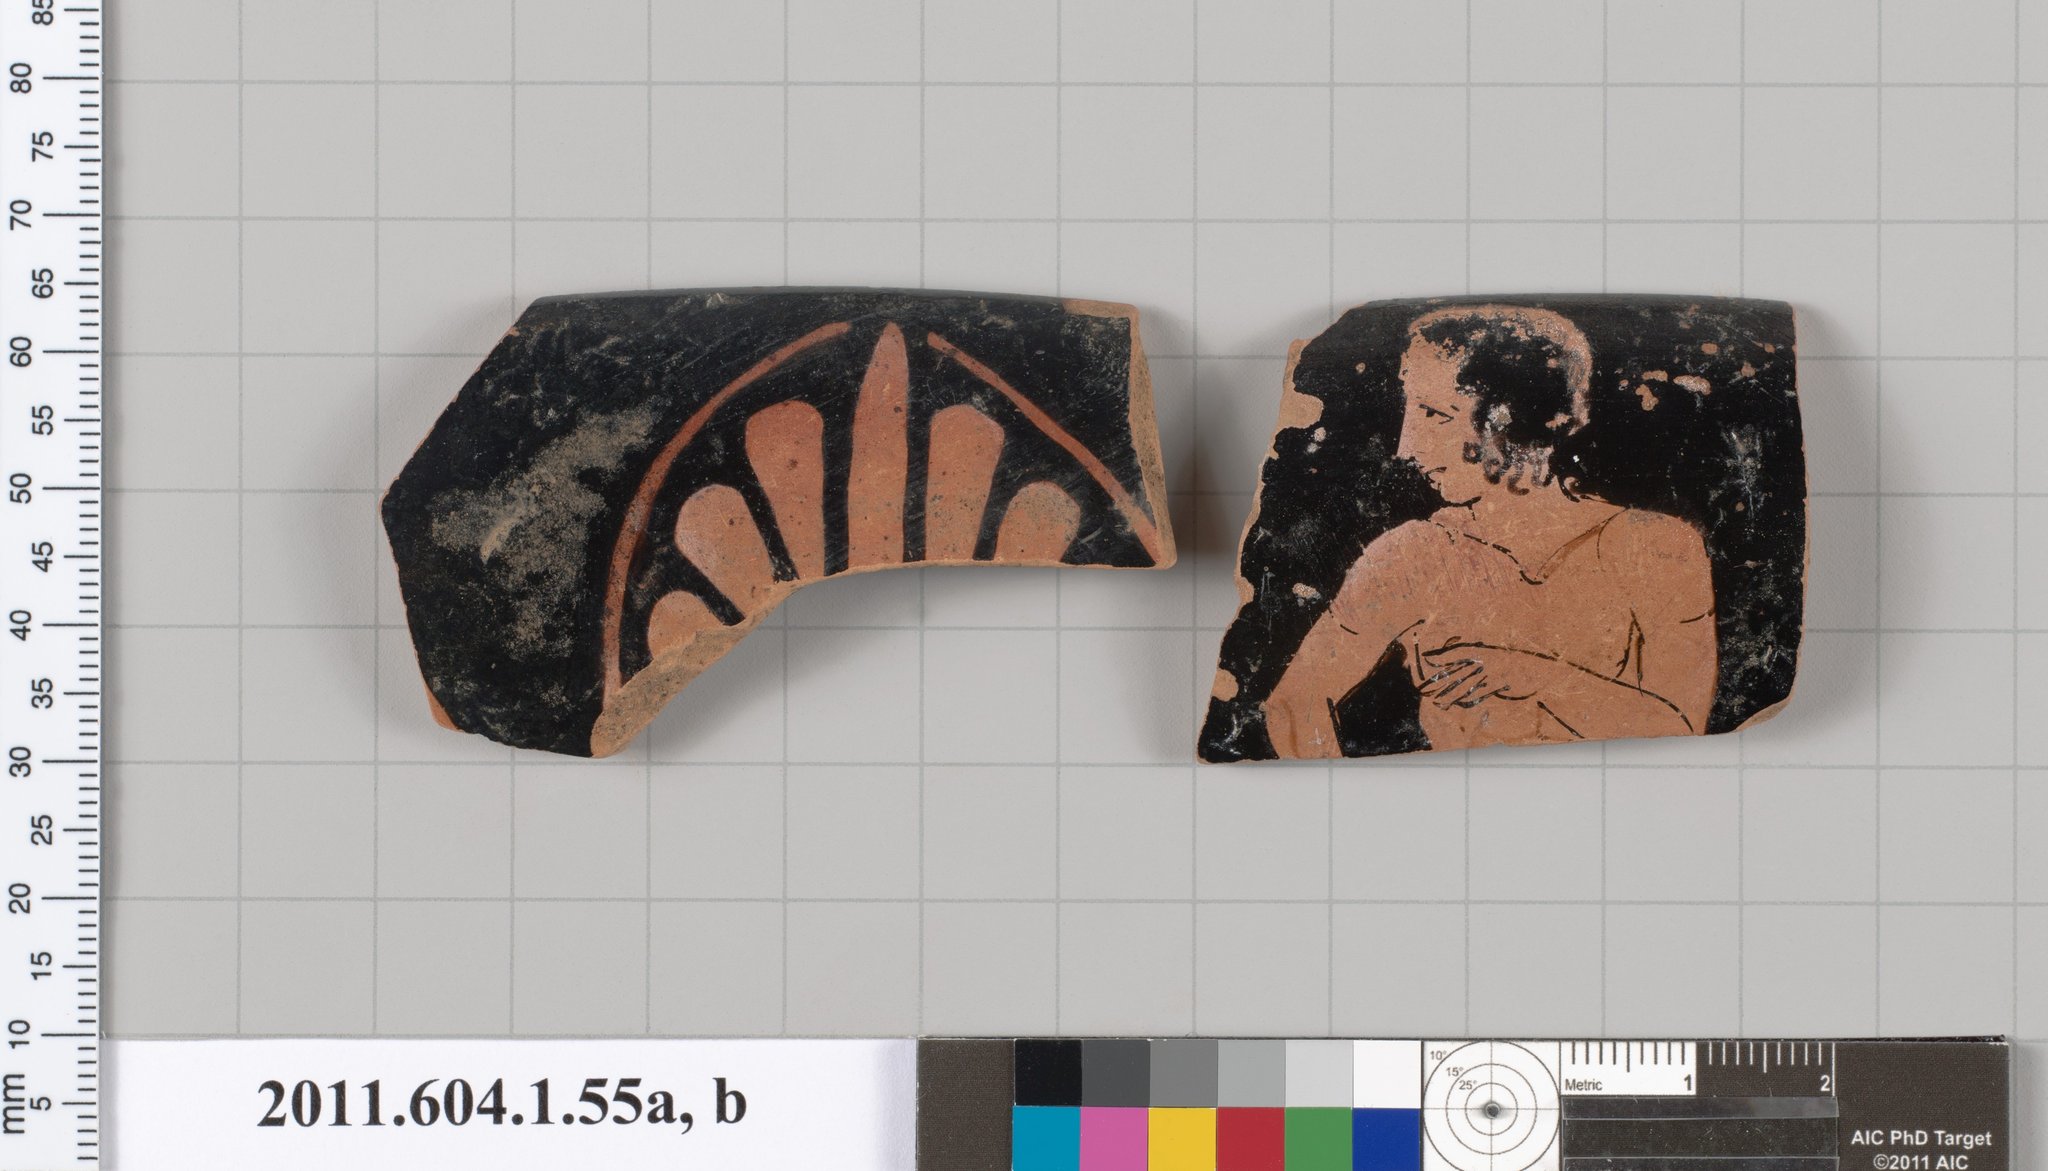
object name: kylix fragment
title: Terracotta rim fragments of a kylix (drinking cup)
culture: greek, attic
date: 467-435 BCE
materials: terracotta